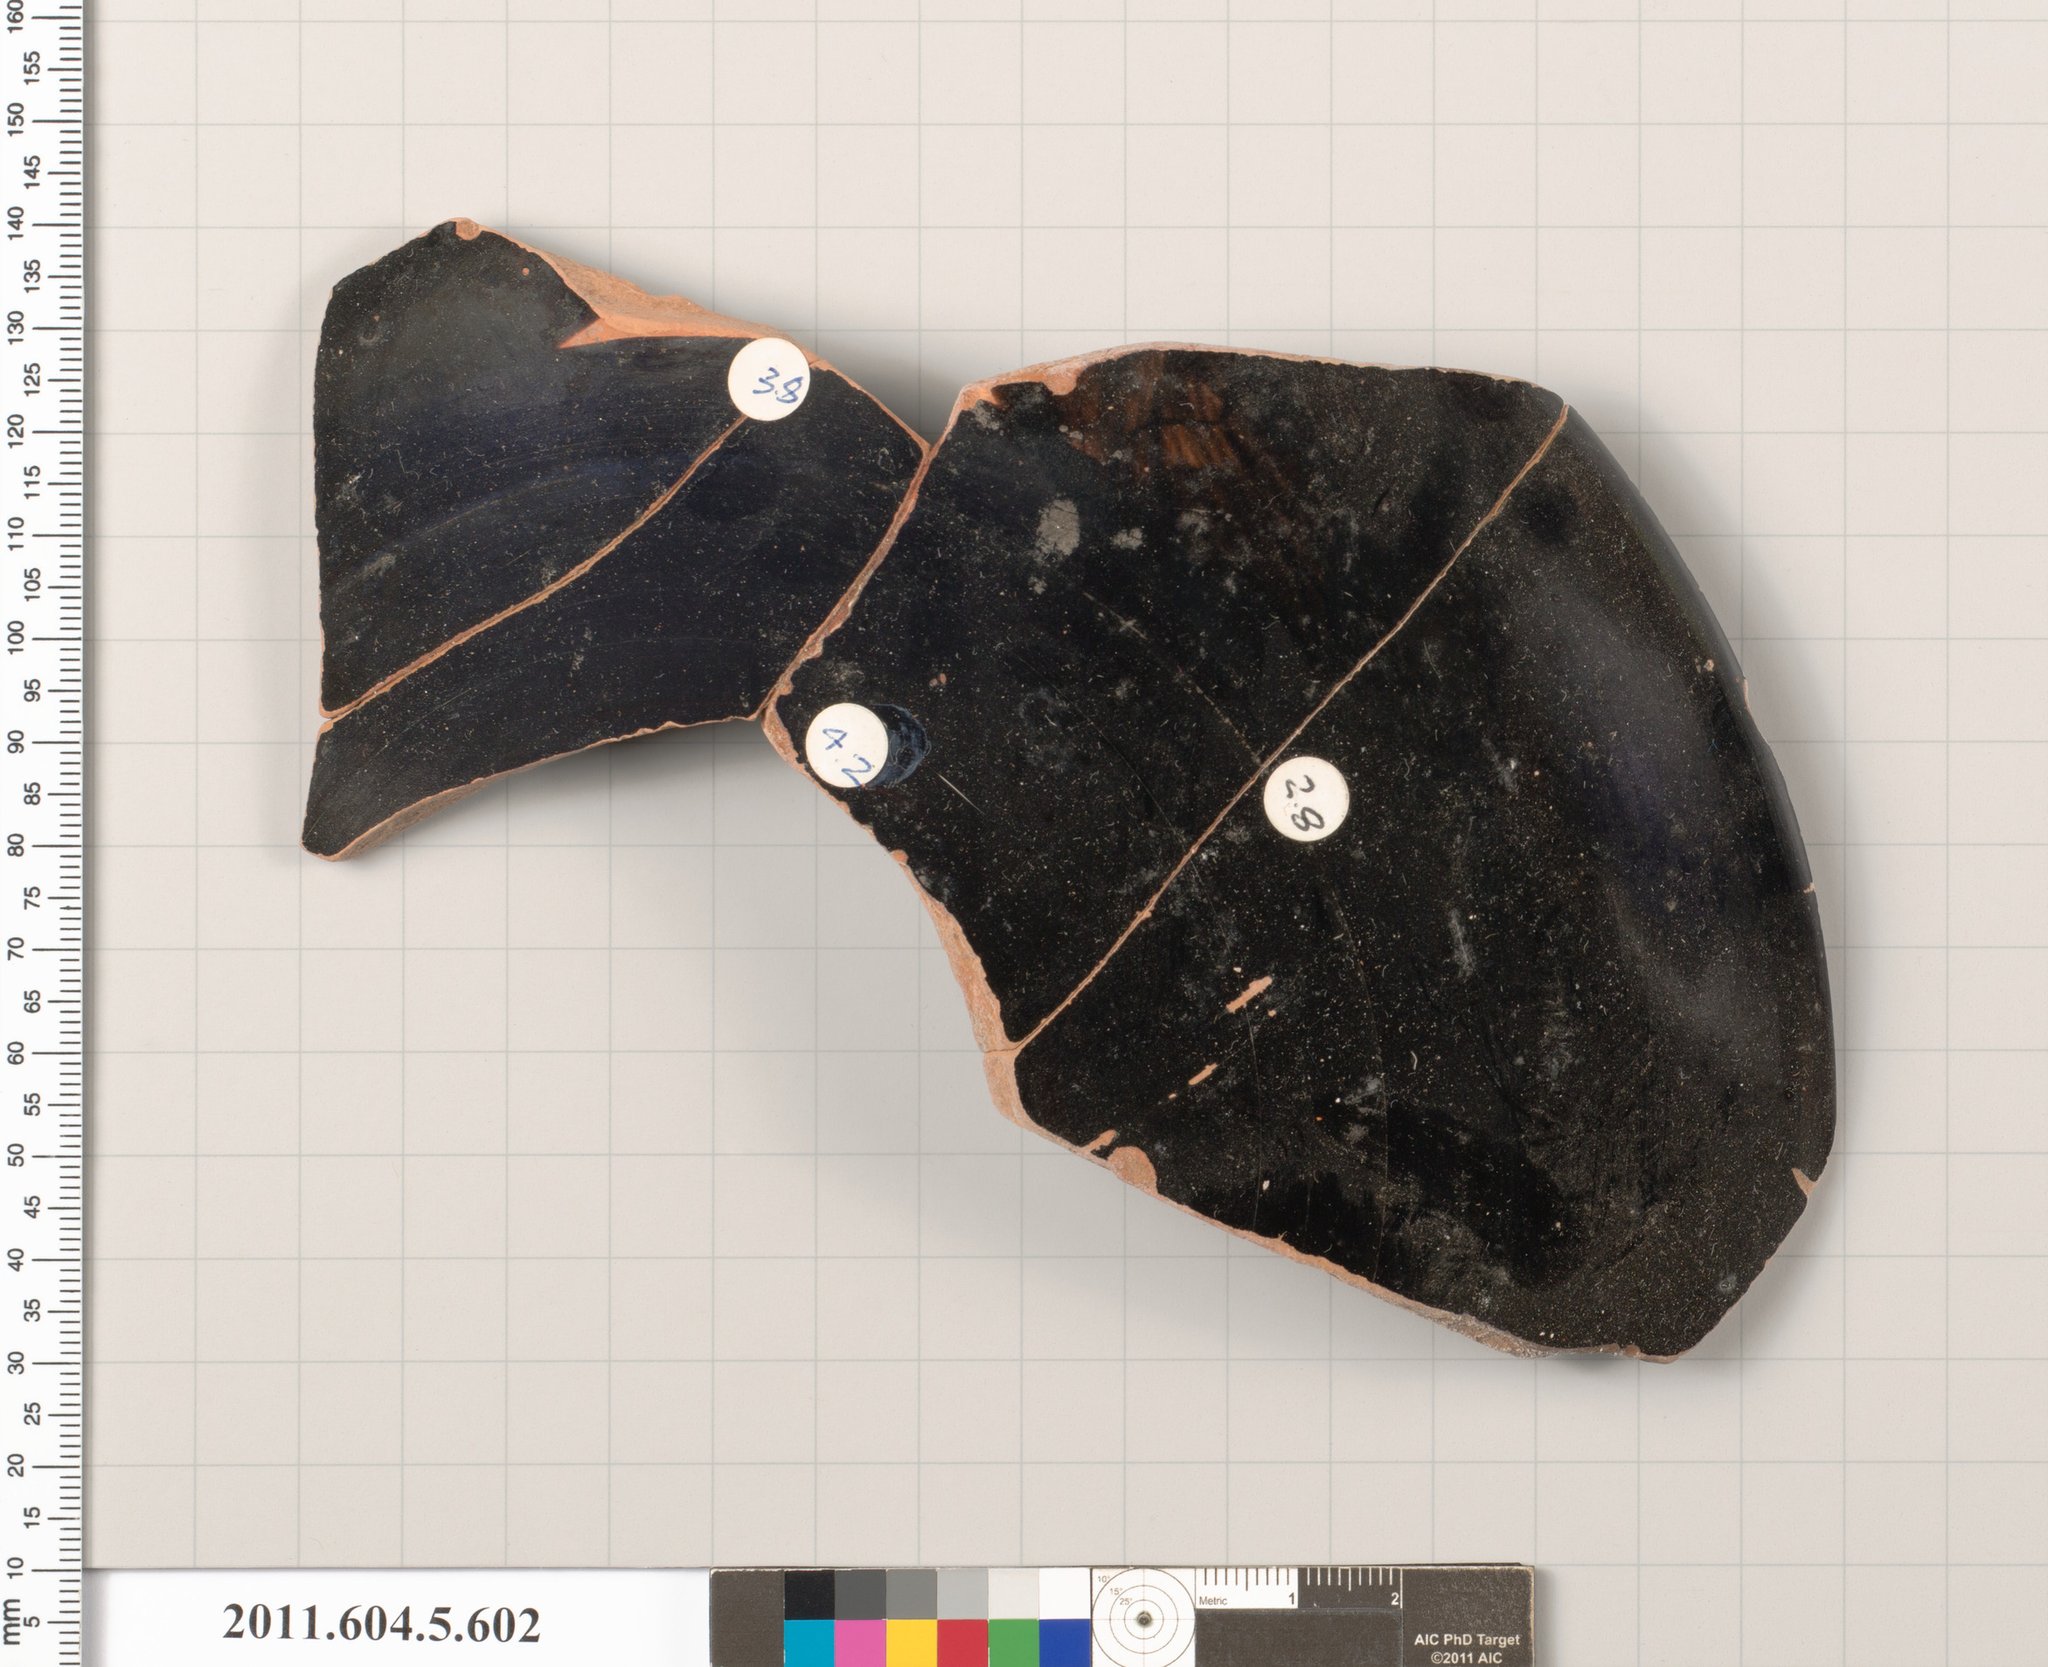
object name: kylix fragment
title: Terracotta rim fragment of a kylix (drinking cup)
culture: greek, attic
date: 600-401 BCE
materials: terracotta